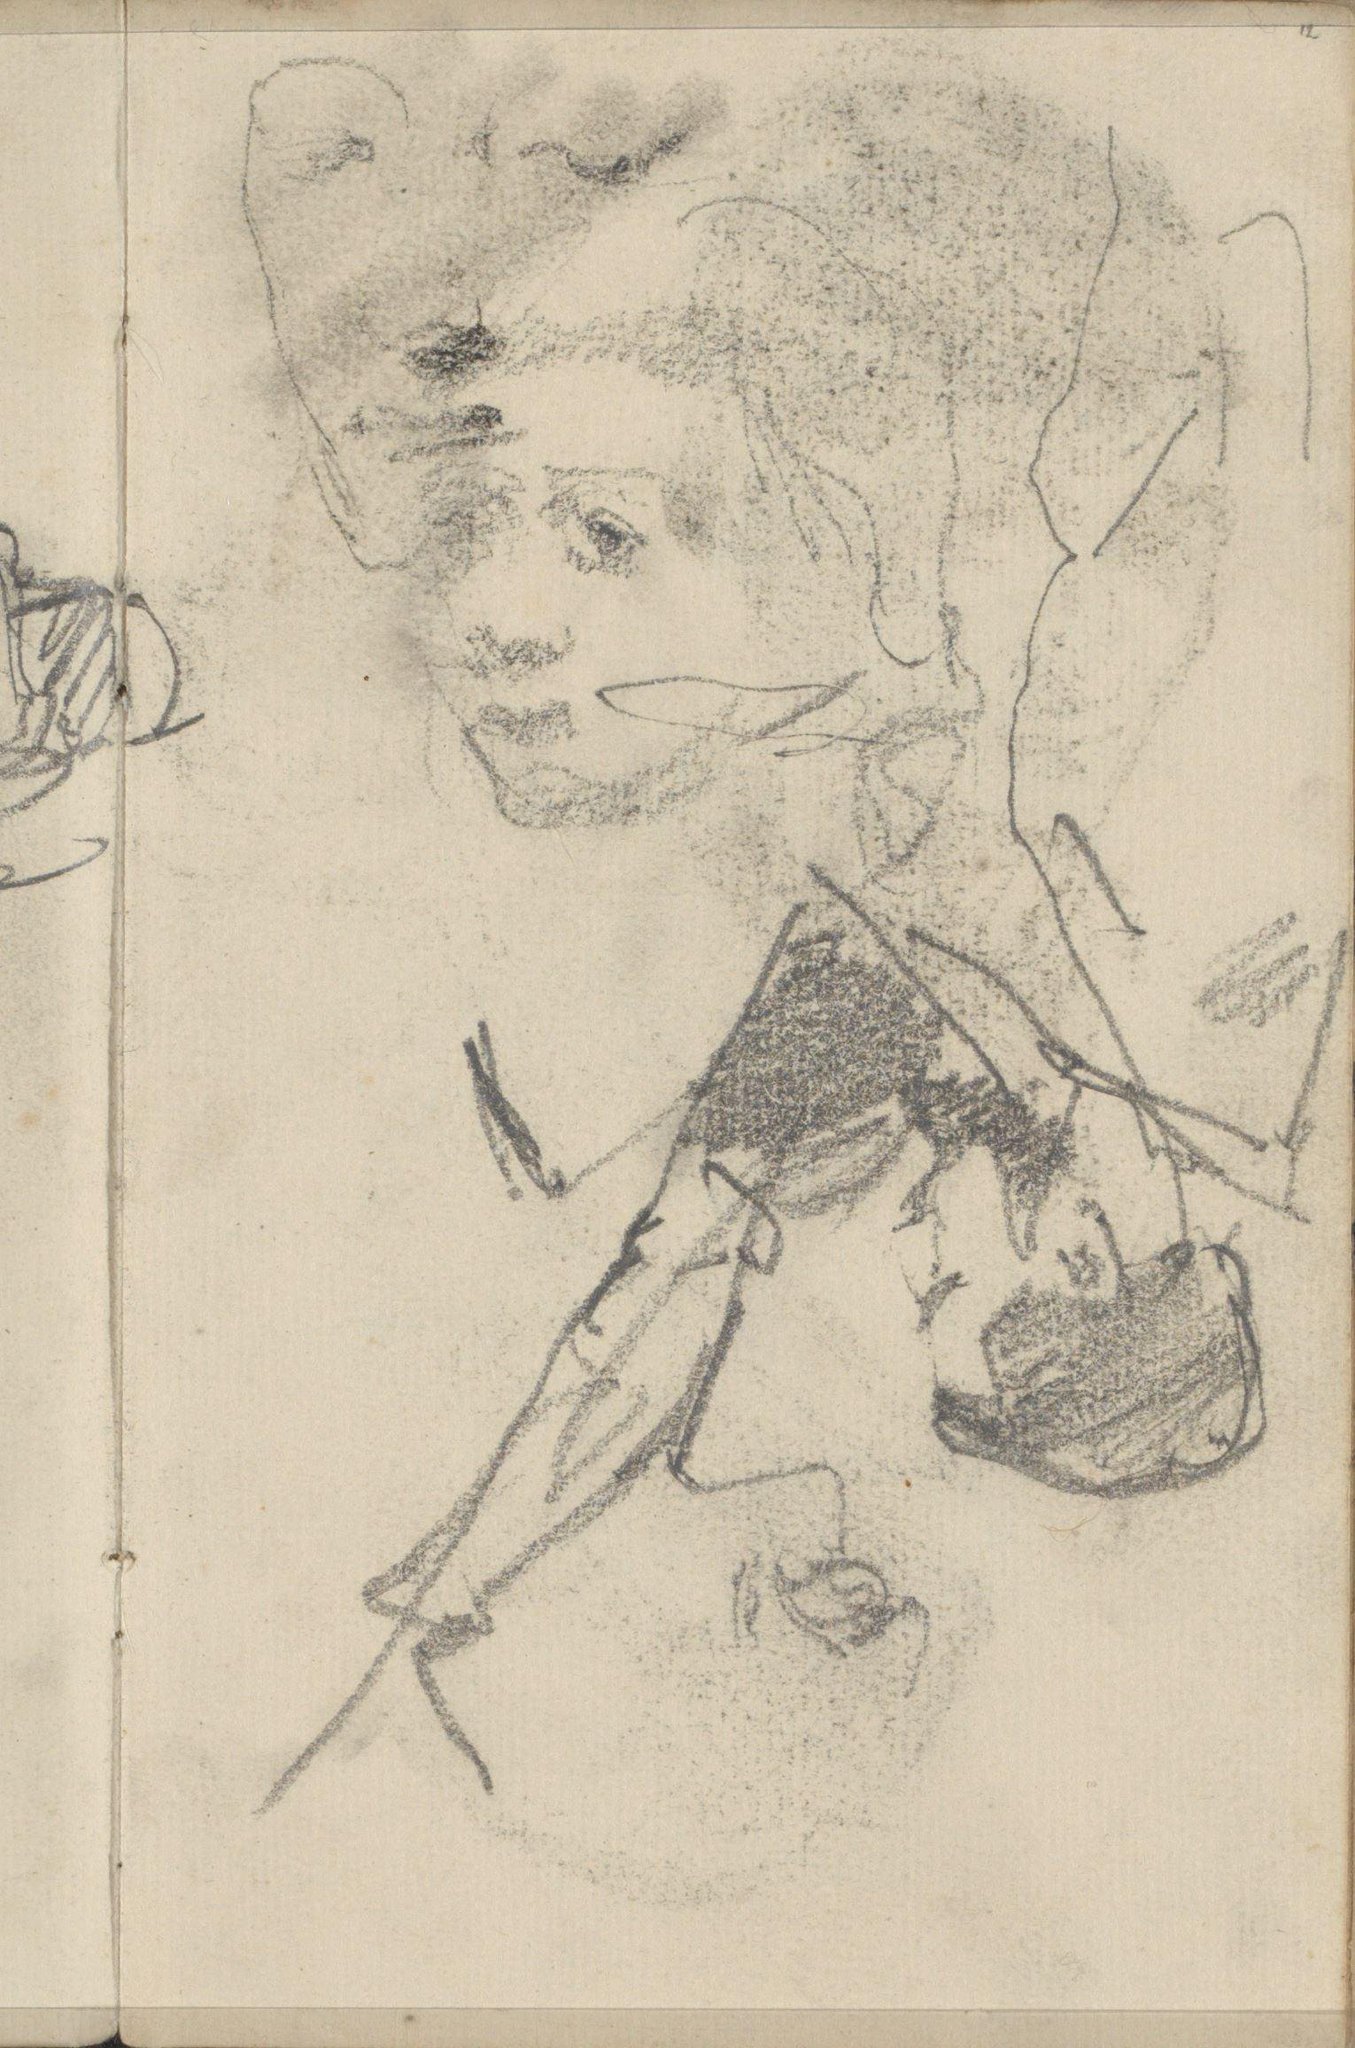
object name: sketchbook leaf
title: Studieblad met hoofden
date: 1882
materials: chalk, paper, pencil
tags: head (human) (+ front view), head (human) (+ three-quarter view), head (human) (+ sideview, profile), child between toddler and youth (of undetermined sex)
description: Onder andere een kinderhoofd en een, mogelijk lezende, man. Pagina 12 uit een schetsboek met 31 bladen vervaardigd te Den Haag en Rotterdam.